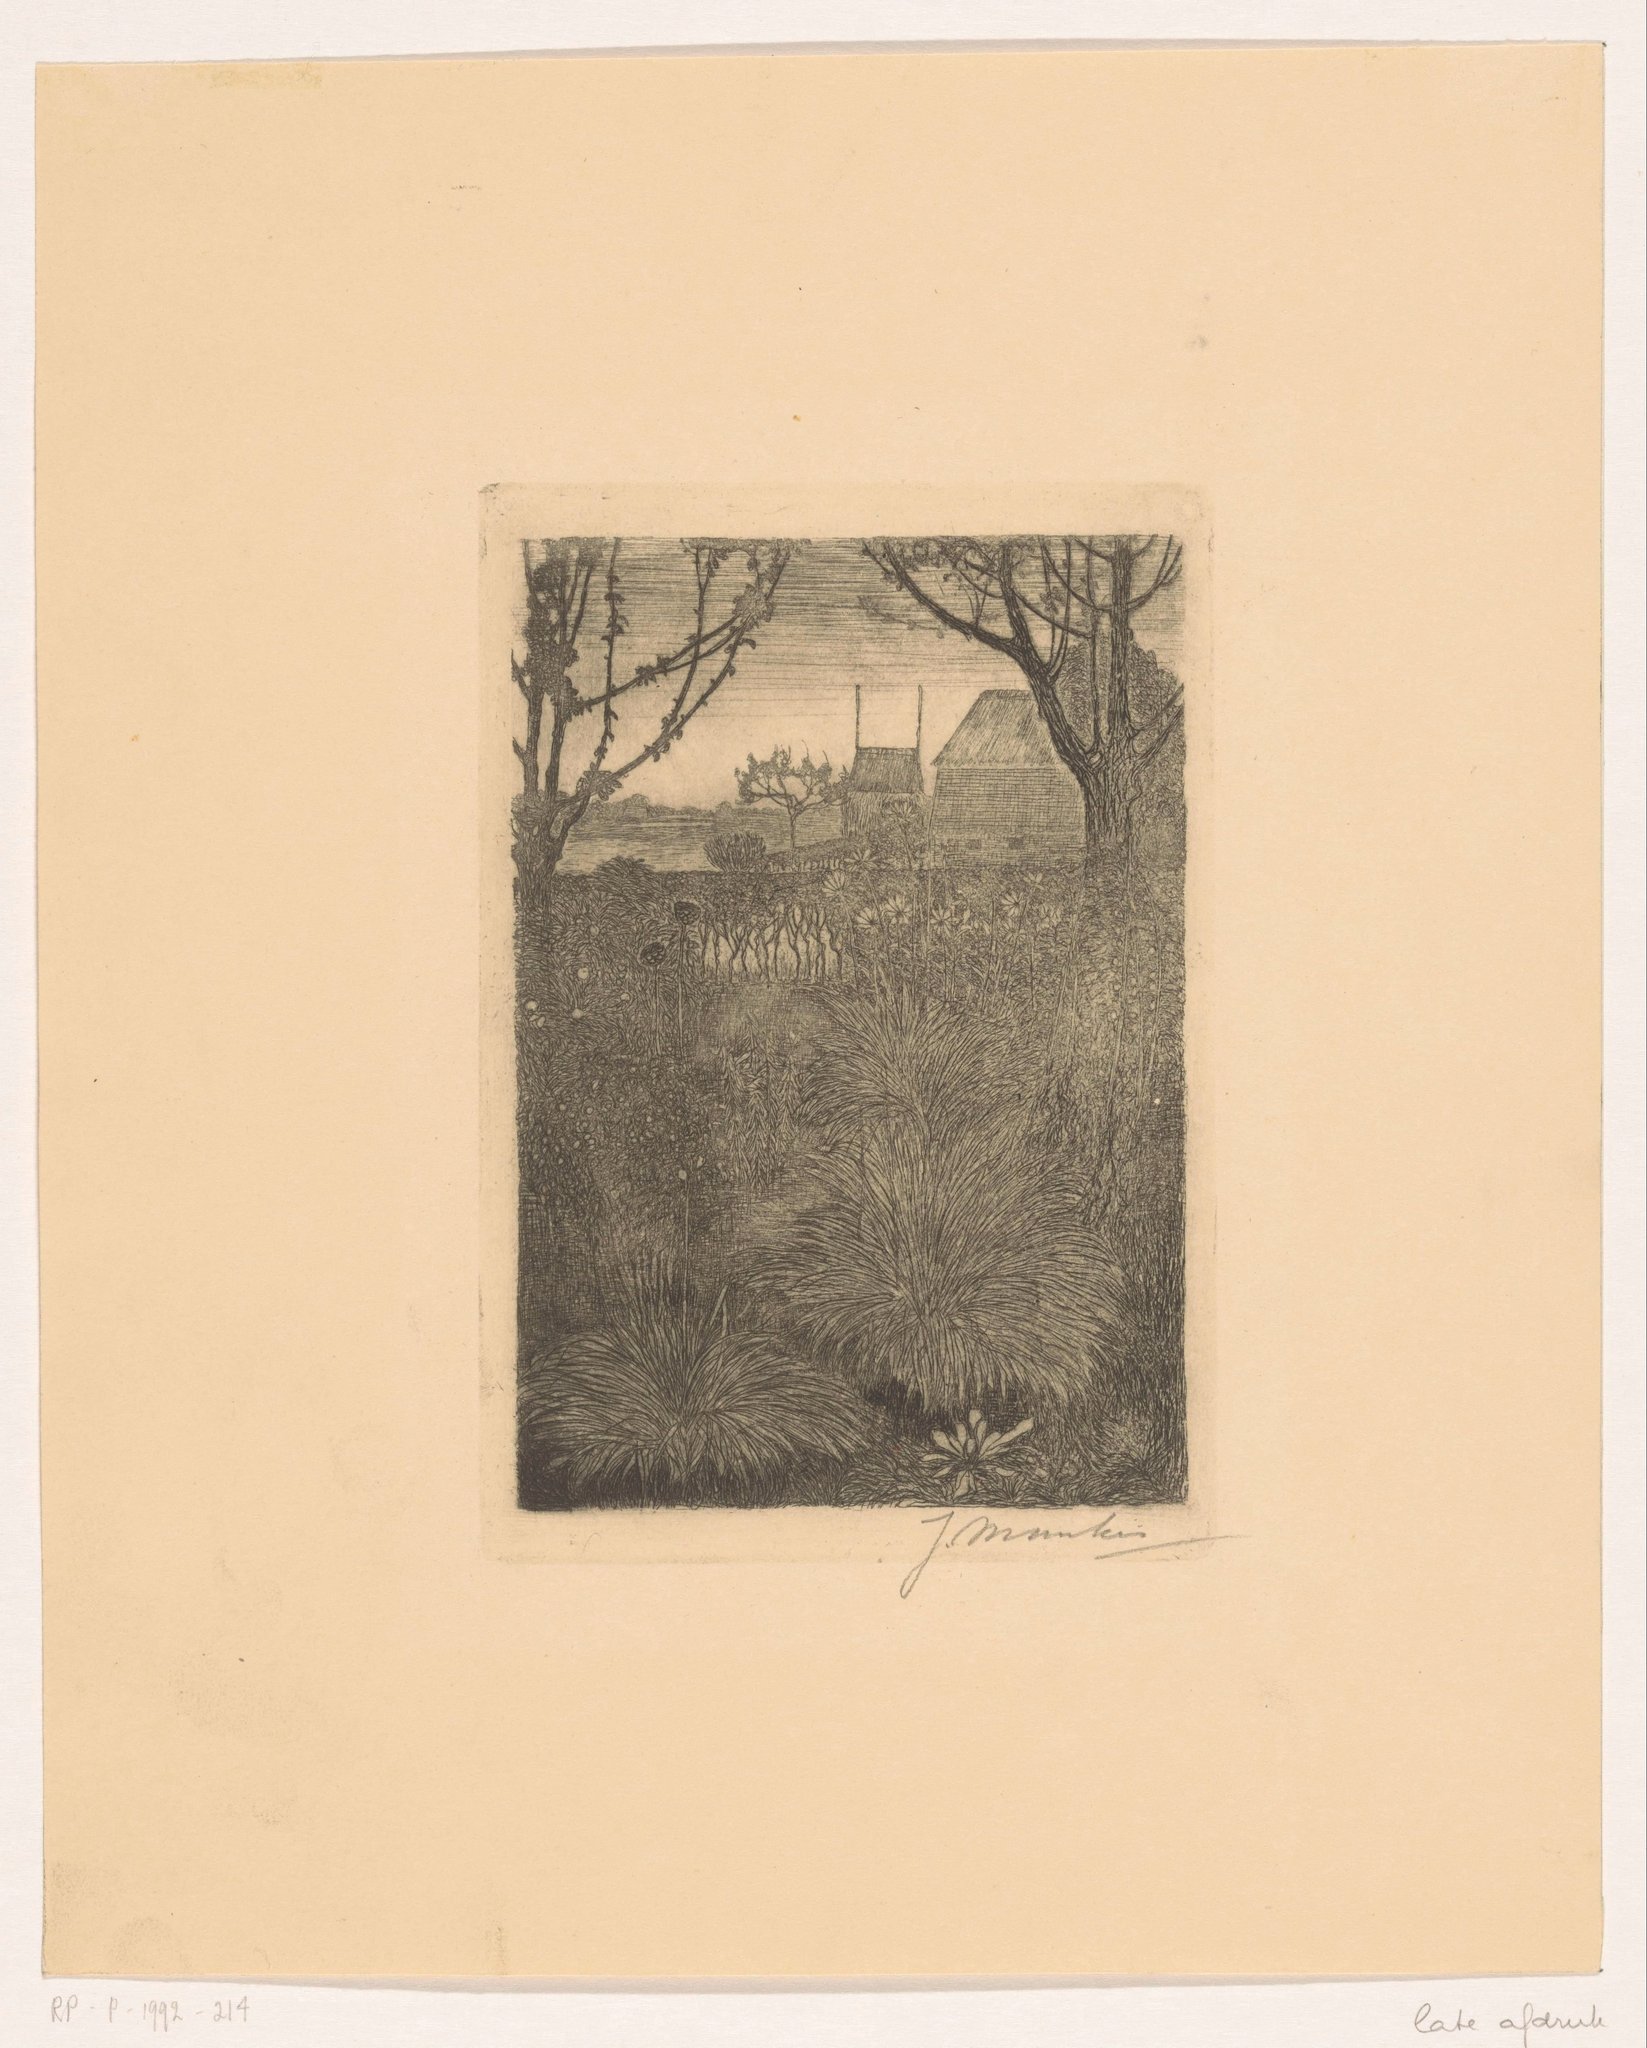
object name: print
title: Gezicht op tuin met struiken en zonnebloemen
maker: jan mankes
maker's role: draughtsman, painter, print maker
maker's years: 1889-1920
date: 1916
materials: paper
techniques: etching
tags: flowers: sunflower, garden, hay-stack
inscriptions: collector's mark: Lugt 2760, collector's mark: Lugt 2228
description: Gezicht op een tuin met struiken en zonnebloemen. Op de achtergrond een boerderijwoning en hooimijt.